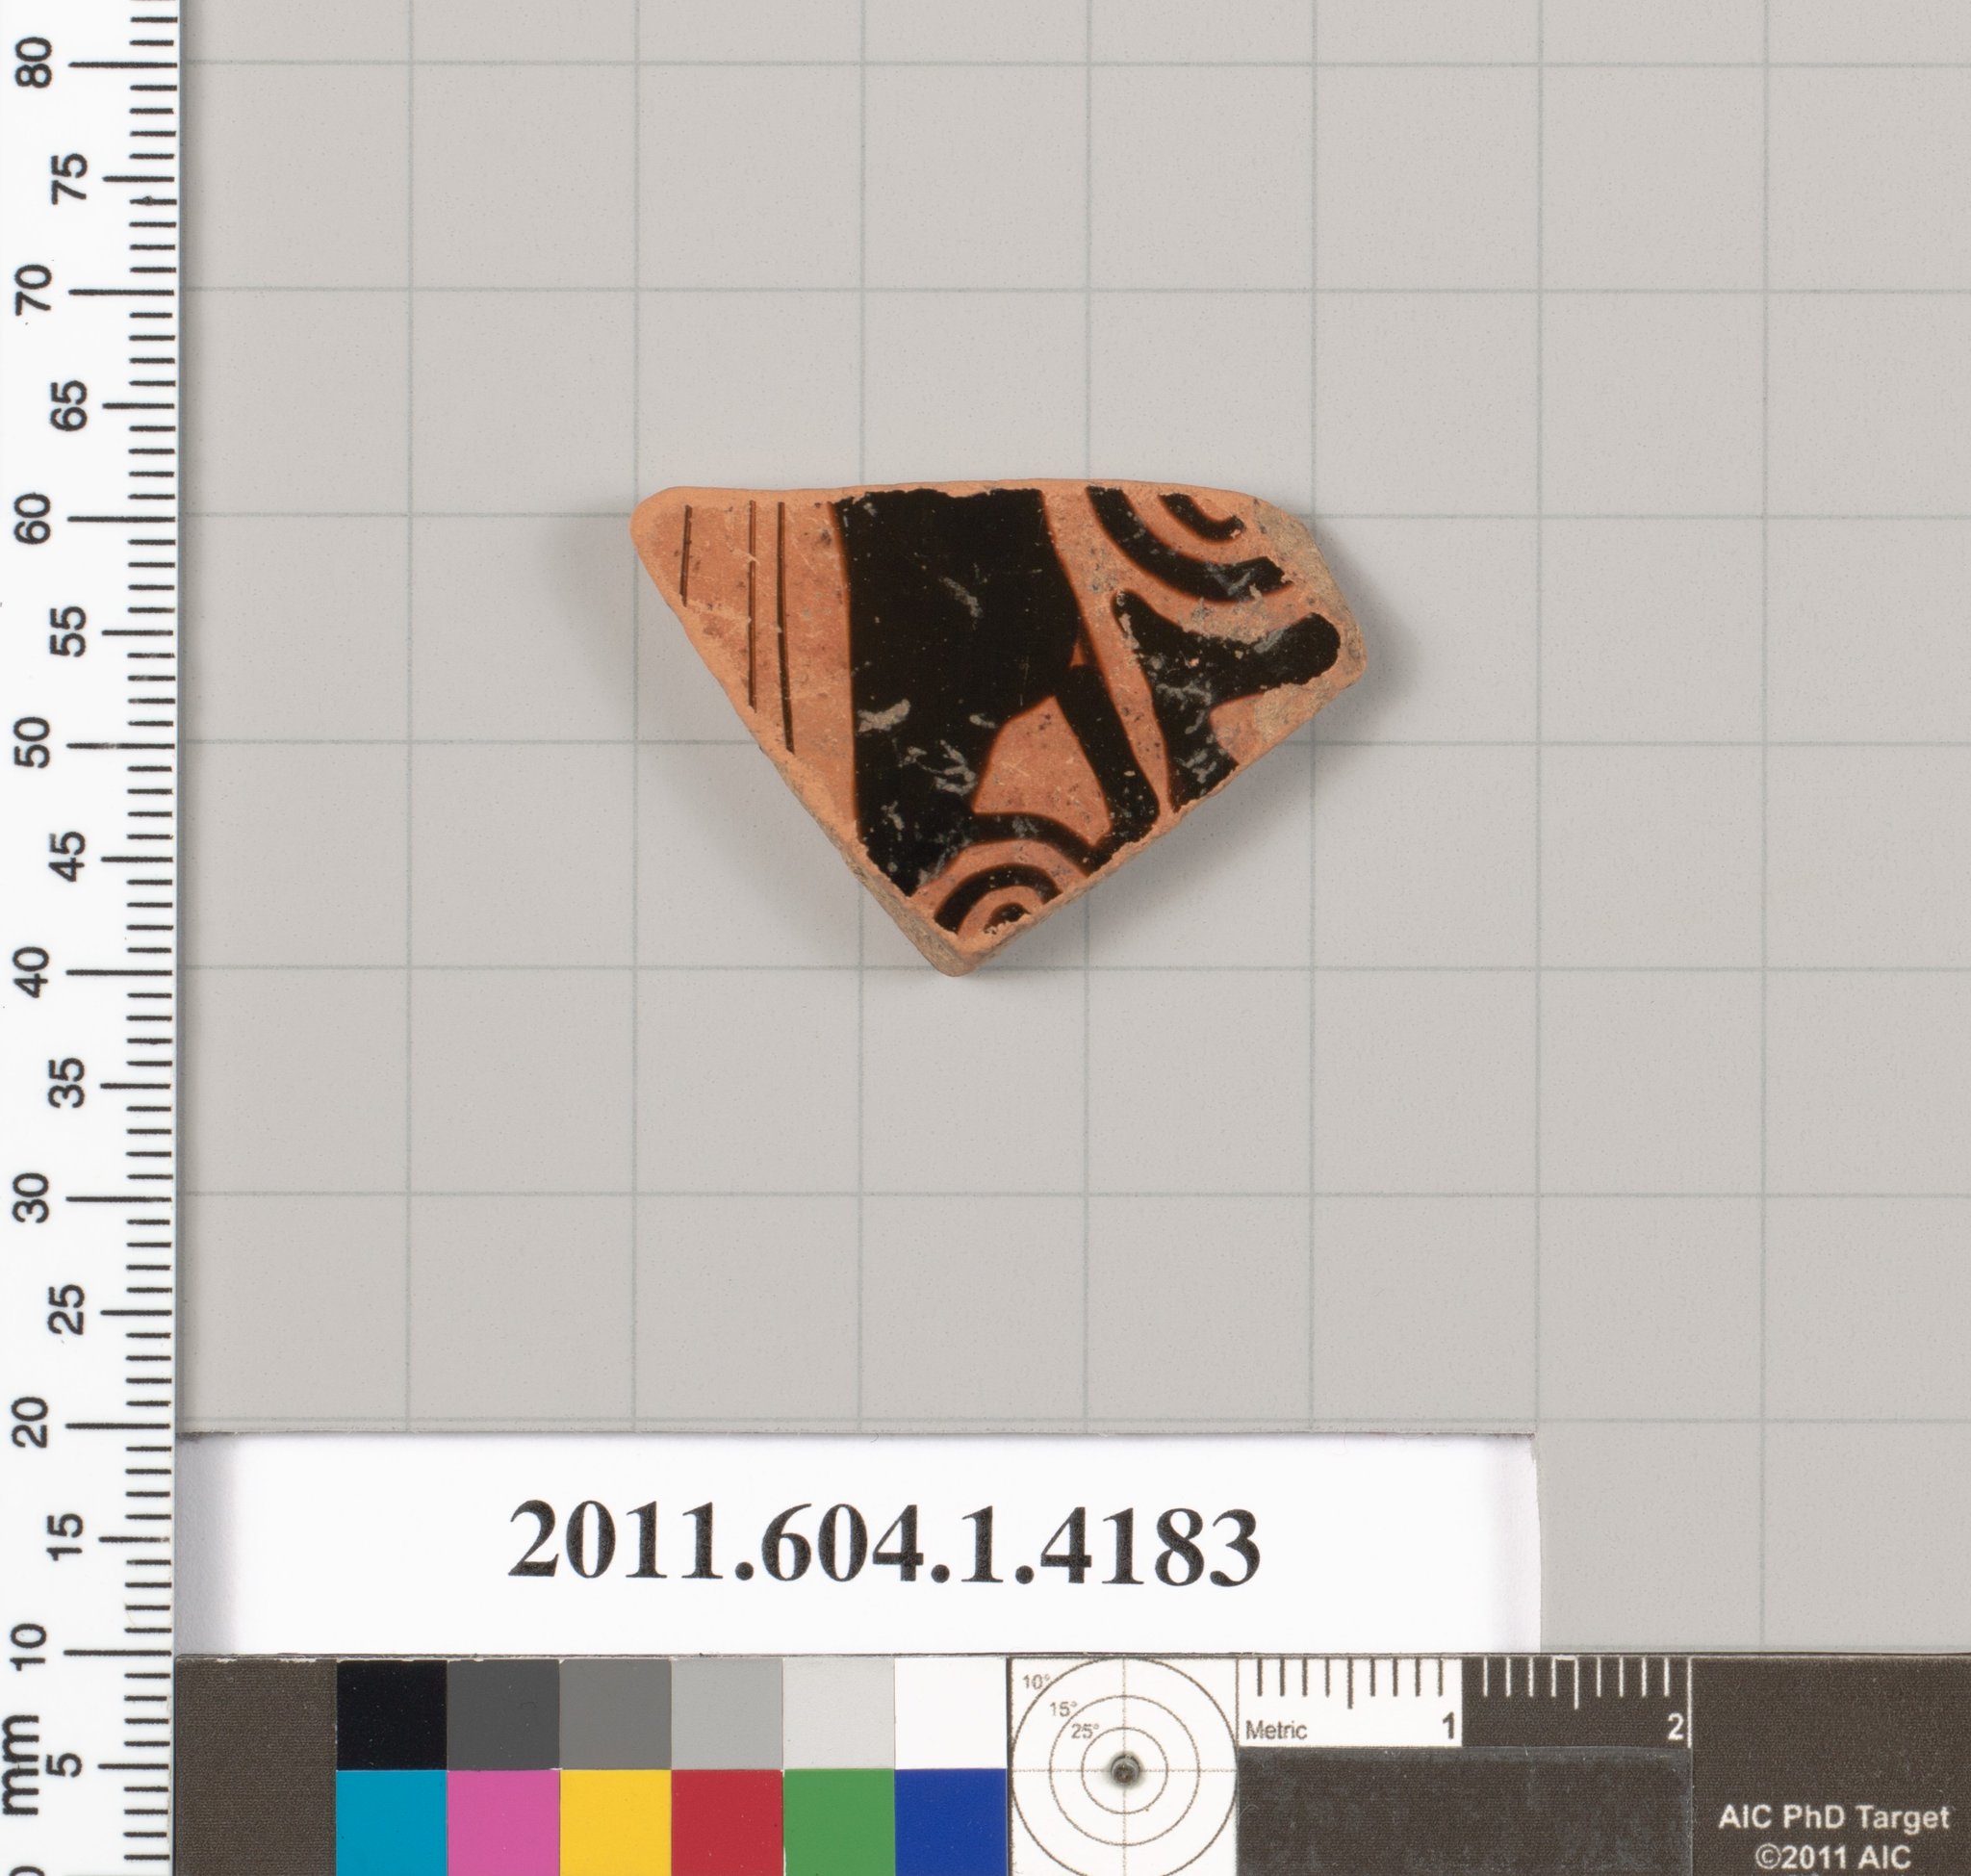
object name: kylix fragment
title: Terracotta fragment of a kylix (drinking cup)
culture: greek, attic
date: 475-451 BCE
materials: terracotta